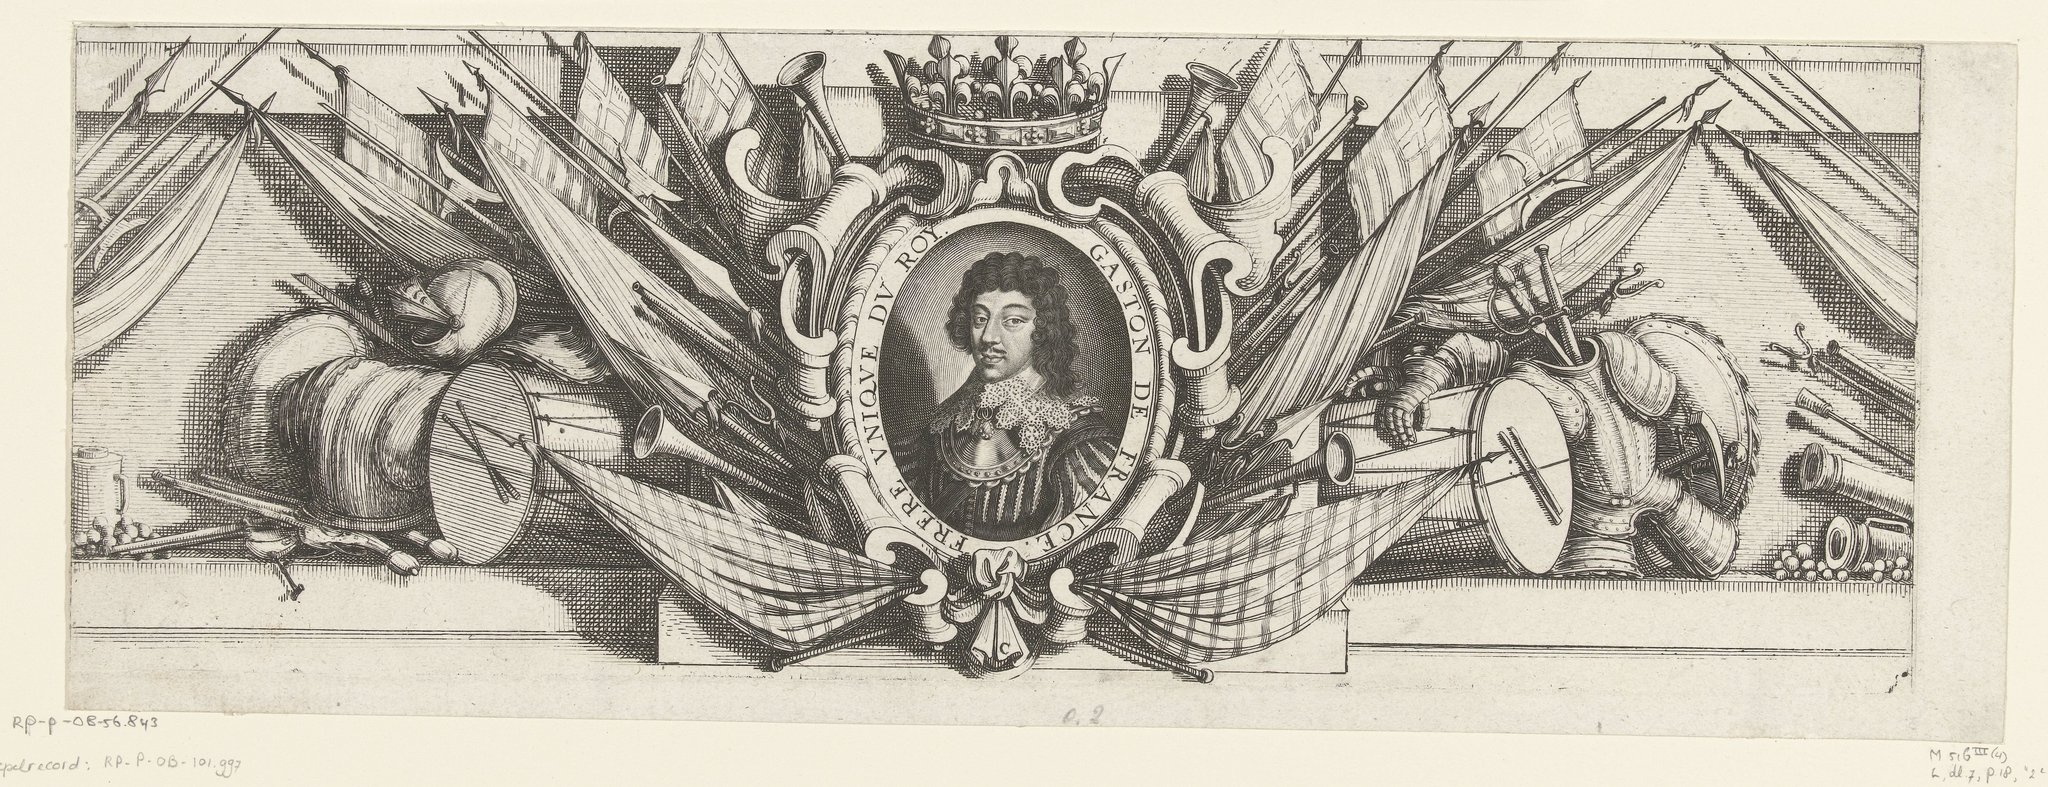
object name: history print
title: Beleg van La Rochelle, september 1627-oktober 1628 (randwerk, deel middenonder)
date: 1628-1631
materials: paper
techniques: engraving, etching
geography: paris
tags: gaston jean-baptiste hertog van orléans, historical persons, ornament ~ cartouche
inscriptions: collector's mark: Lugt 240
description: Zestiende deel (randwerk, deel middenonder) van een prent van het beleg van het hugenotenbolwerk La Rochelle in de jaren 1627 en 1628, dat werd uitgevoerd in opdracht van de Franse koning door het Franse leger onder aanvoering van kardinaal Richelieu. Op dit blad een portret van de broer van Lodewijk XIII, Gaston, in ovaal met randschrift, omgeven door een kroon en militaire attributen.